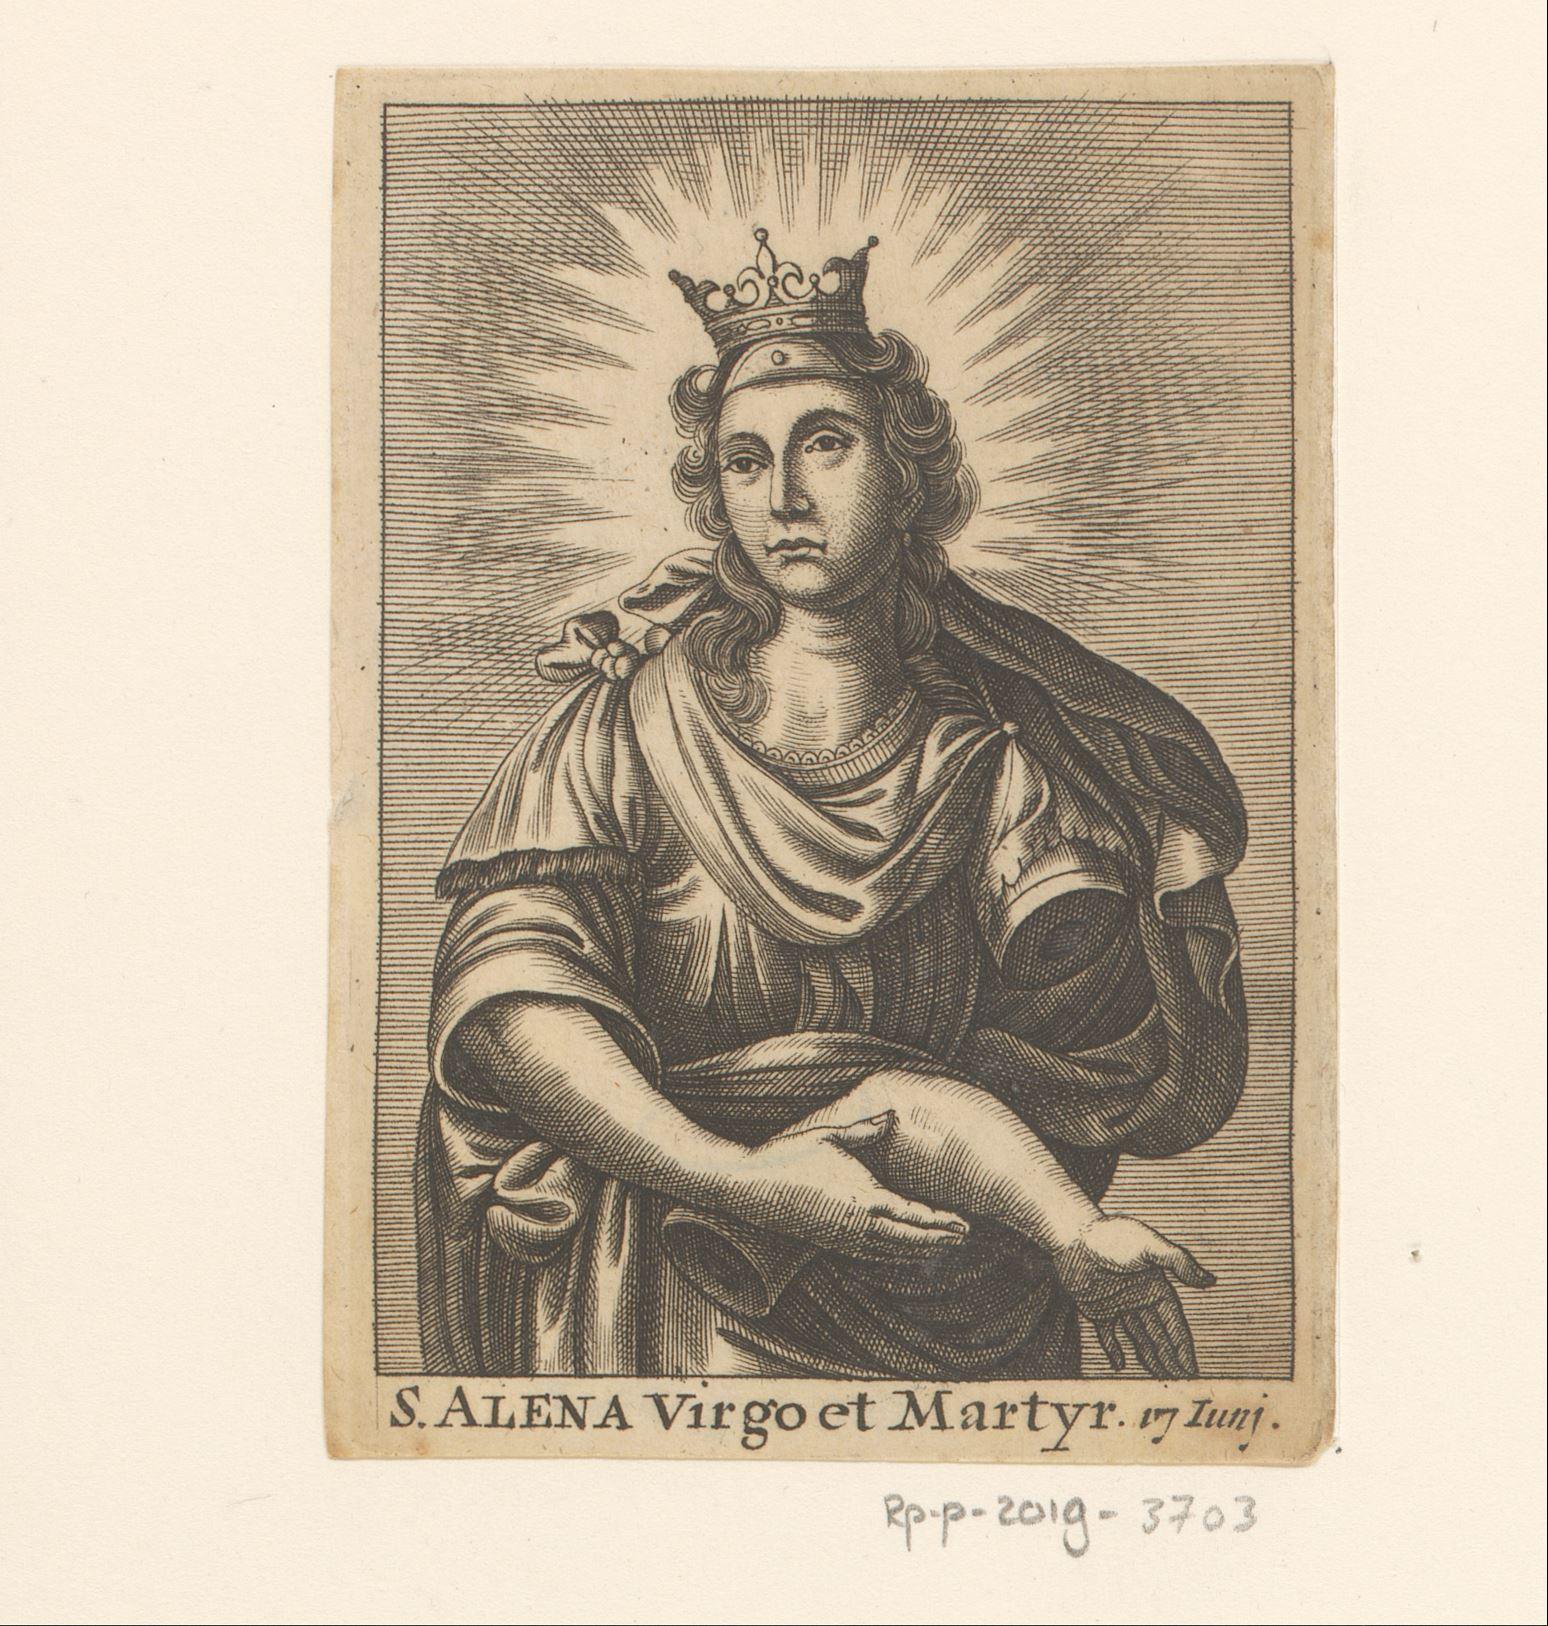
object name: print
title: H. Alena van Dilbeek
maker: Anonymous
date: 1600-1699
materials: paper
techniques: engraving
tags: female saints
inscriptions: collector's mark: Lugt 2228